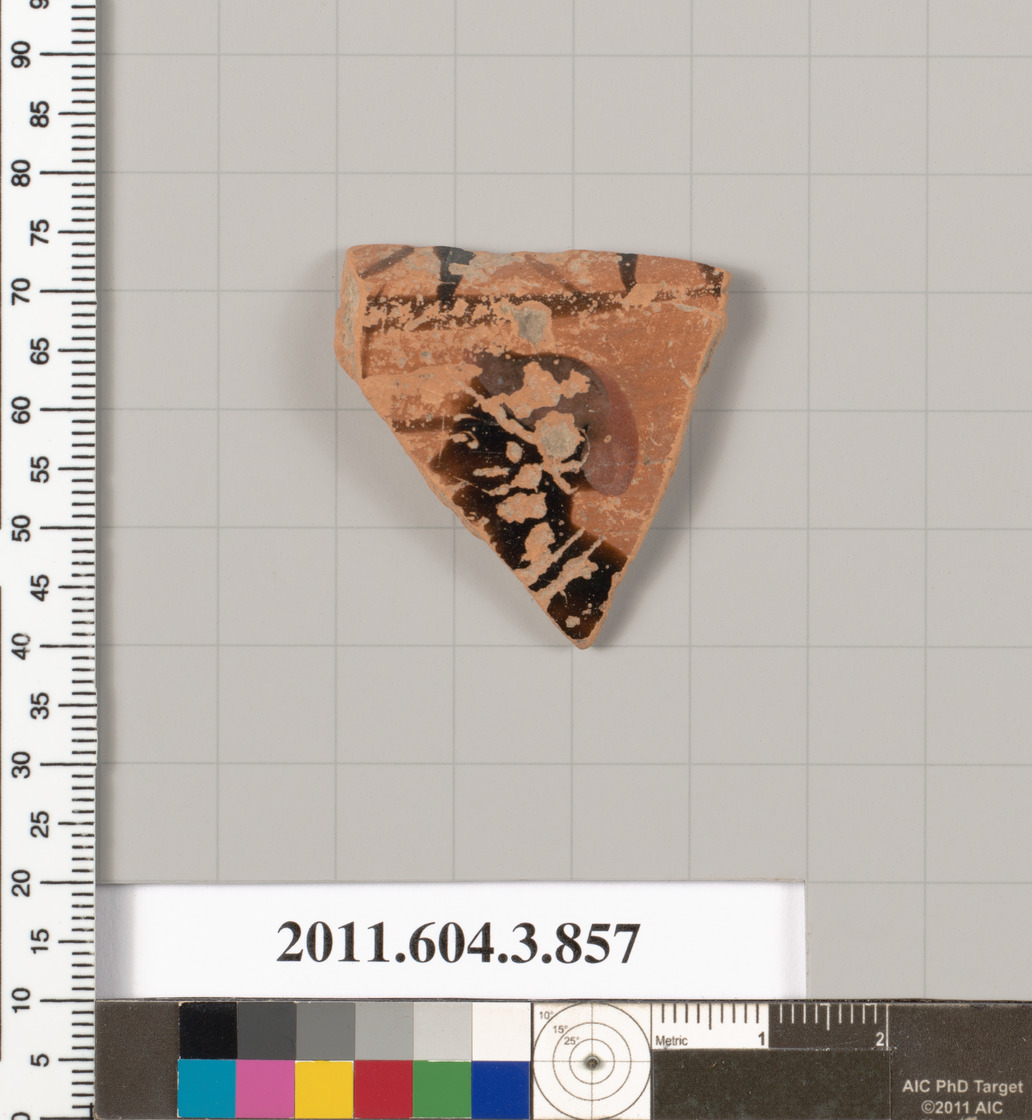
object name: lekythos fragment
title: Terracotta fragment of a lekythos (oil flask)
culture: greek, attic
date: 500-468 BCE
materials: terracotta